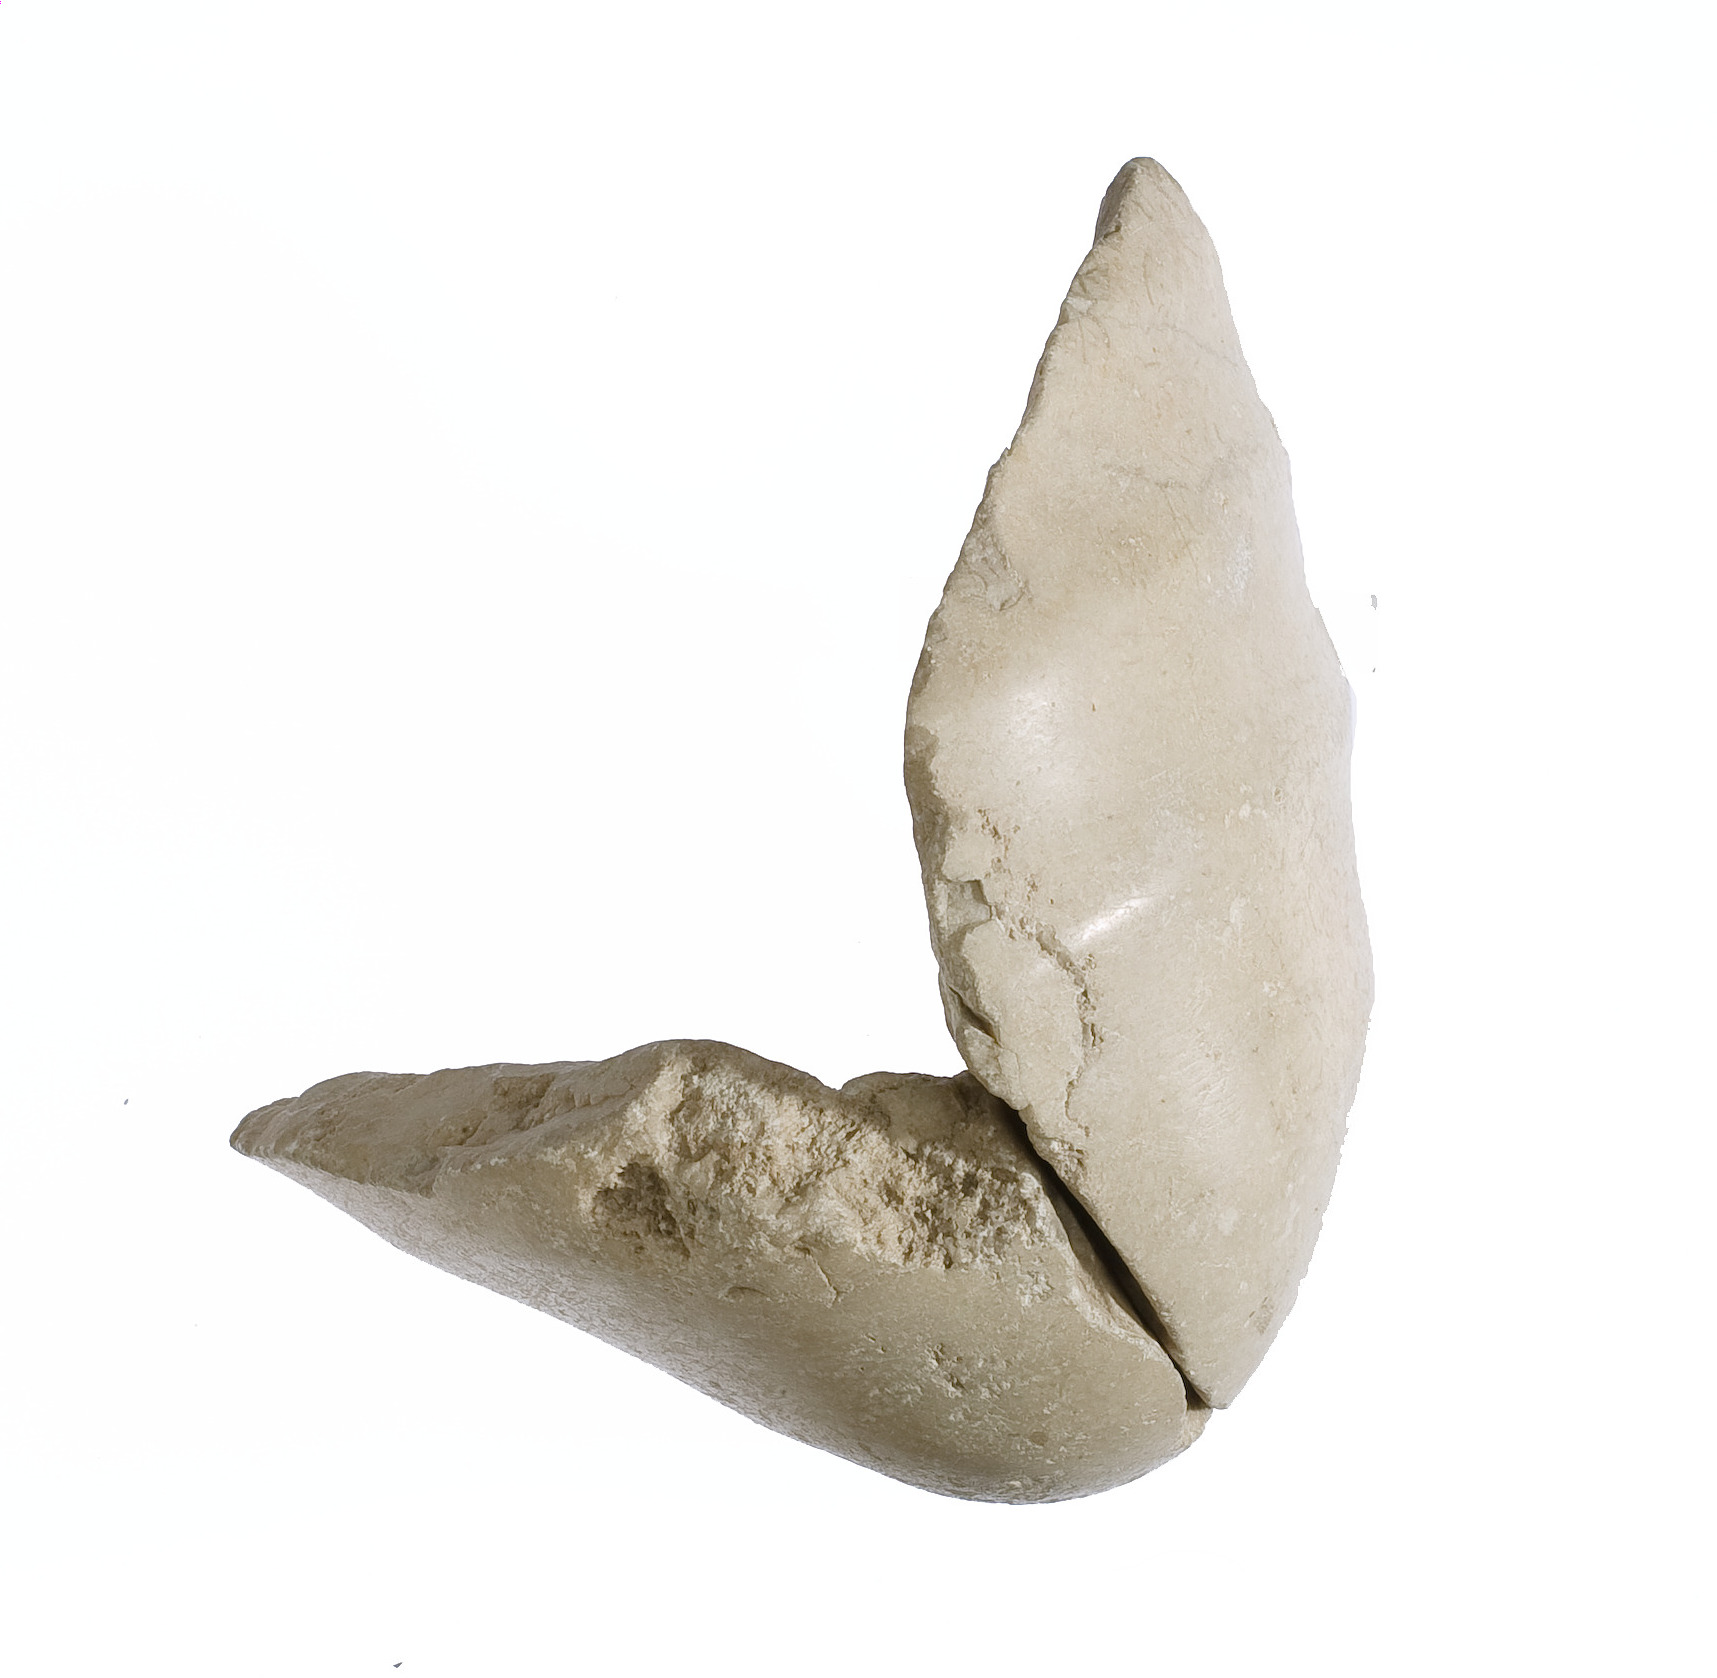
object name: elbow, with garment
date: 1353-1336 BCE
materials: limestone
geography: egypt